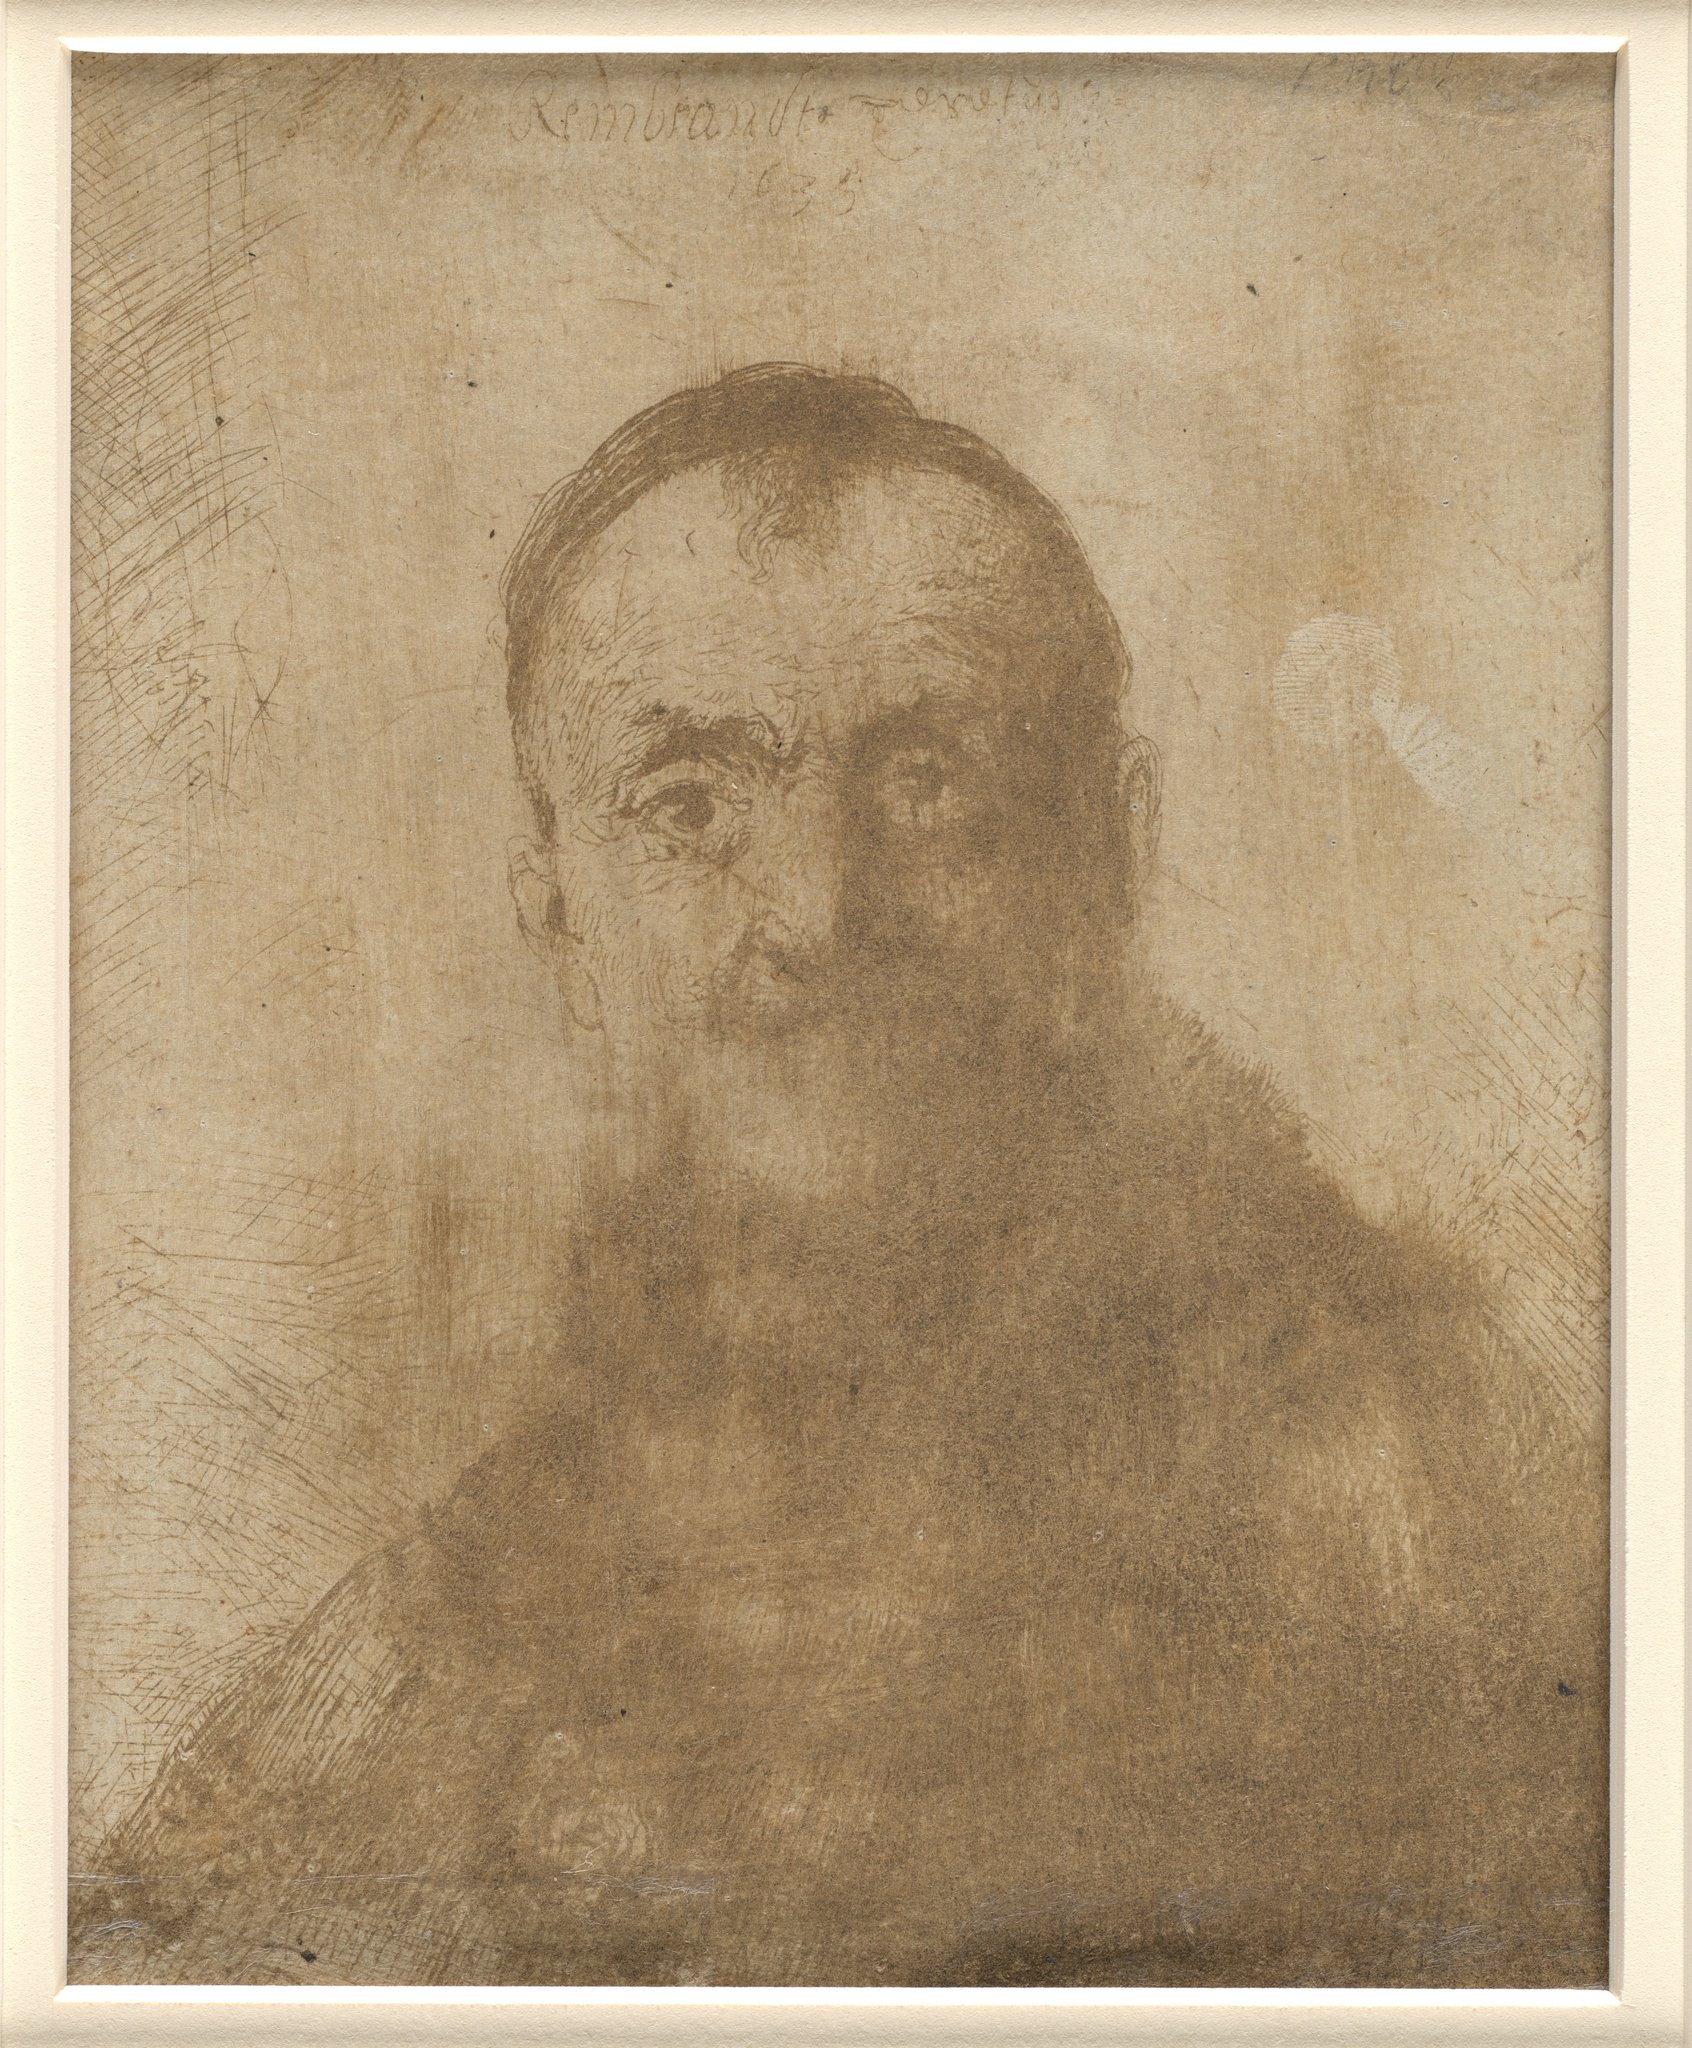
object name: drawing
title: A Young Man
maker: school of rembrandt van rijn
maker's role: artist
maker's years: 1606-1669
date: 1635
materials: ink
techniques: brush, pen, printing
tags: men,portraits